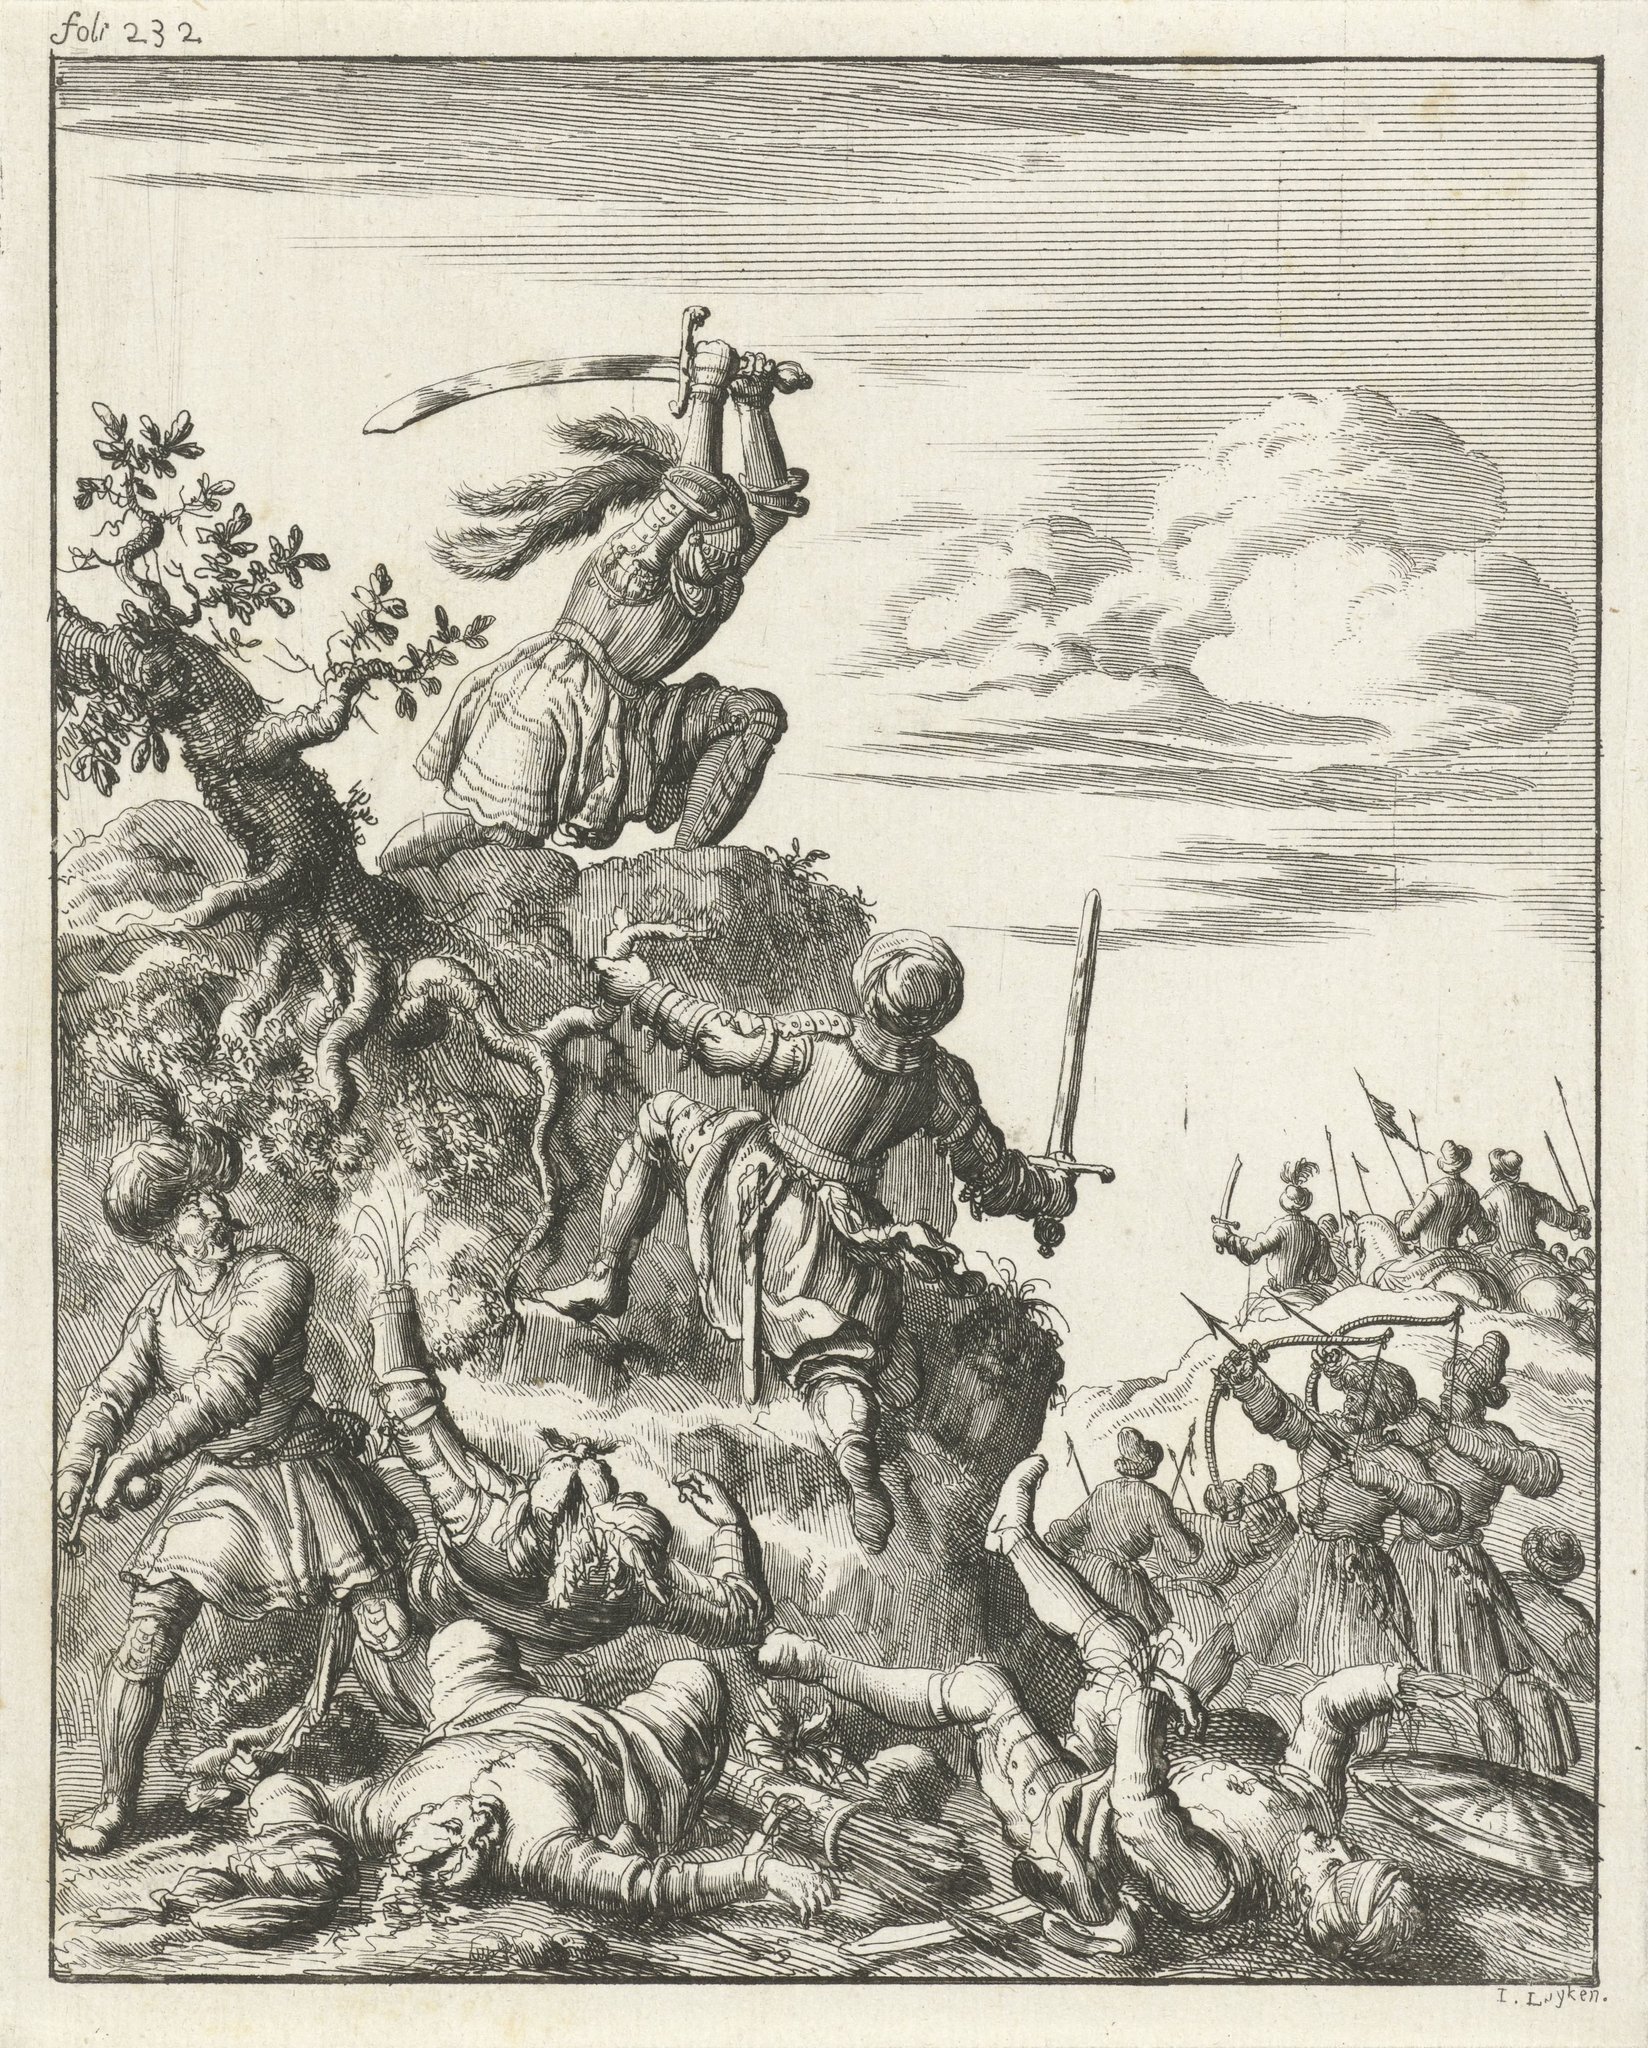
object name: book illustration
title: Lodewijk VII, koning van Frankrijk, vecht bij Laodicea alleen tegen de vijand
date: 1683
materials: paper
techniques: etching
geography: amsterdam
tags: battle, militant proselytizing: religious war, crusade, etc.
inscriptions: collector's mark: Lugt 2228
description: Illustratie opgenomen in: Maimbourg, Louis. Historie der kruisvaarders, tot de verlossing van't heilig land. Amsterdam: Timotheus ten Hoorn, 1683.